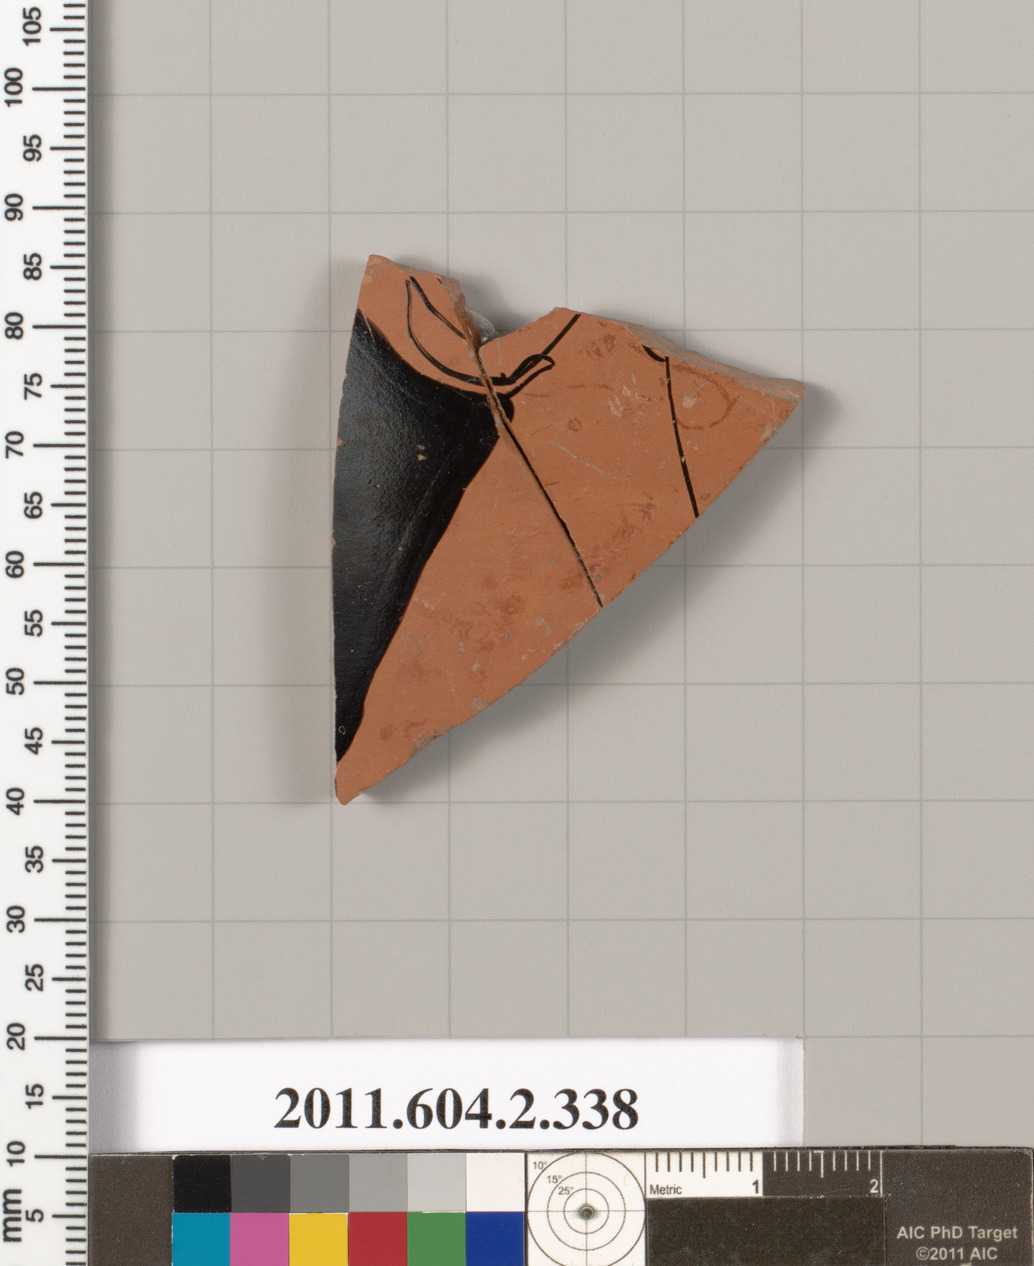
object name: column krater fragment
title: Terracotta fragment of a column-krater (bowl for mixing wine and water)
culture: greek, attic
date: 460-440 BCE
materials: terracotta